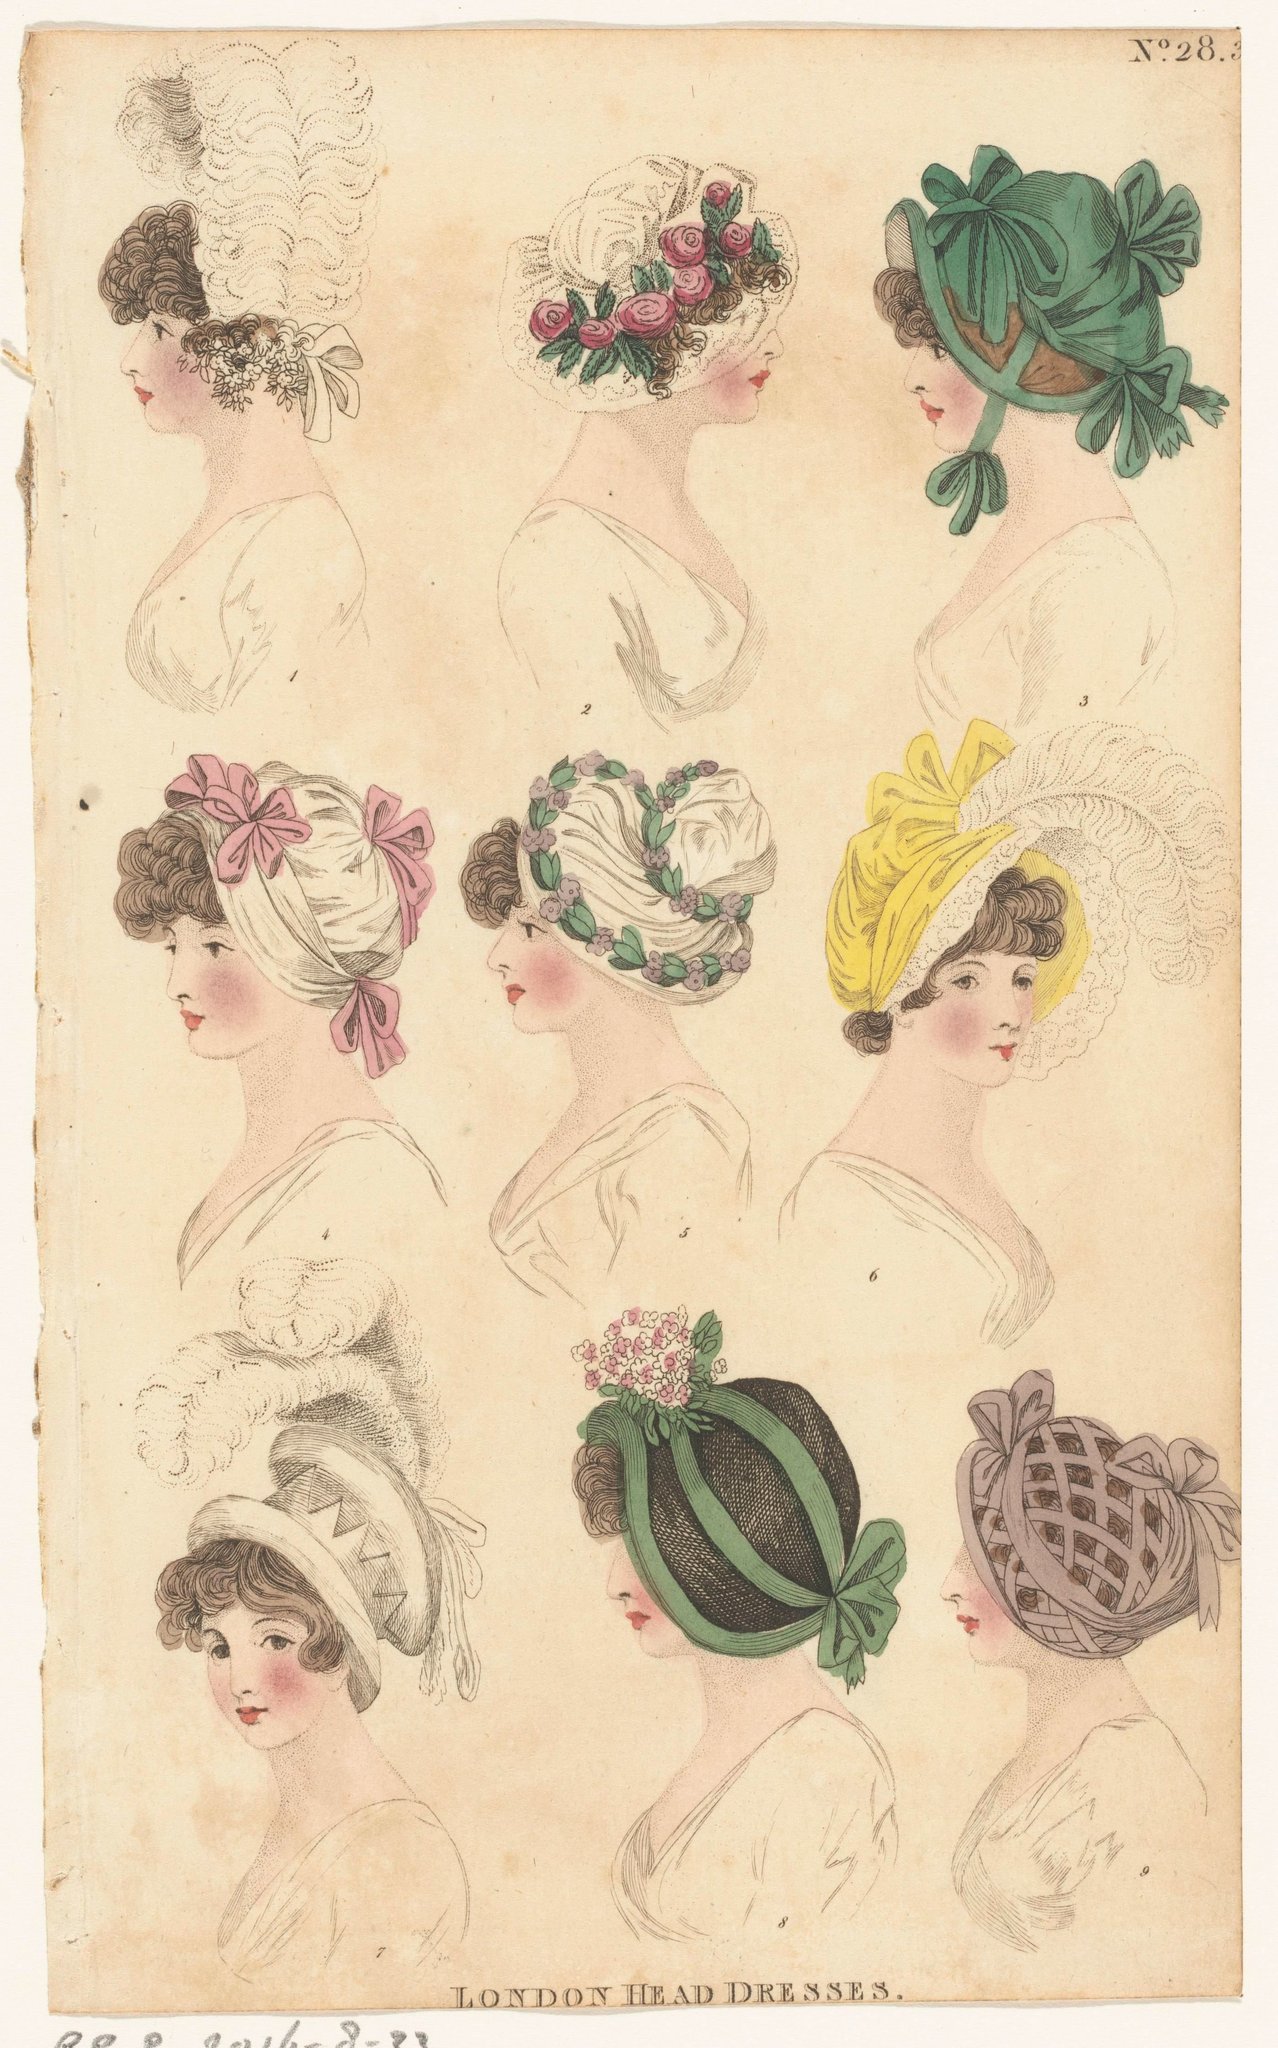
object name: fashion print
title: Magazine of Female Fashions of London and Paris, No.28: London Head Dresses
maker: richard phillips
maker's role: bookseller, publisher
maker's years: 1767-1840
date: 1798-1806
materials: paper, ink, watercolor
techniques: engraving, etching, hand coloring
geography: london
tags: head-gear (capote) (+ women's clothes), head-gear: cap (+ women's clothes), fashion plates, head-gear: hat (+ women's clothes)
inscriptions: caption: ‘LONDON HEAD DRESSES’, collector's mark: Lugt 2228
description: Negen verschillende Engelse hoeden en mutsen voor vrouwen, ca. 1800